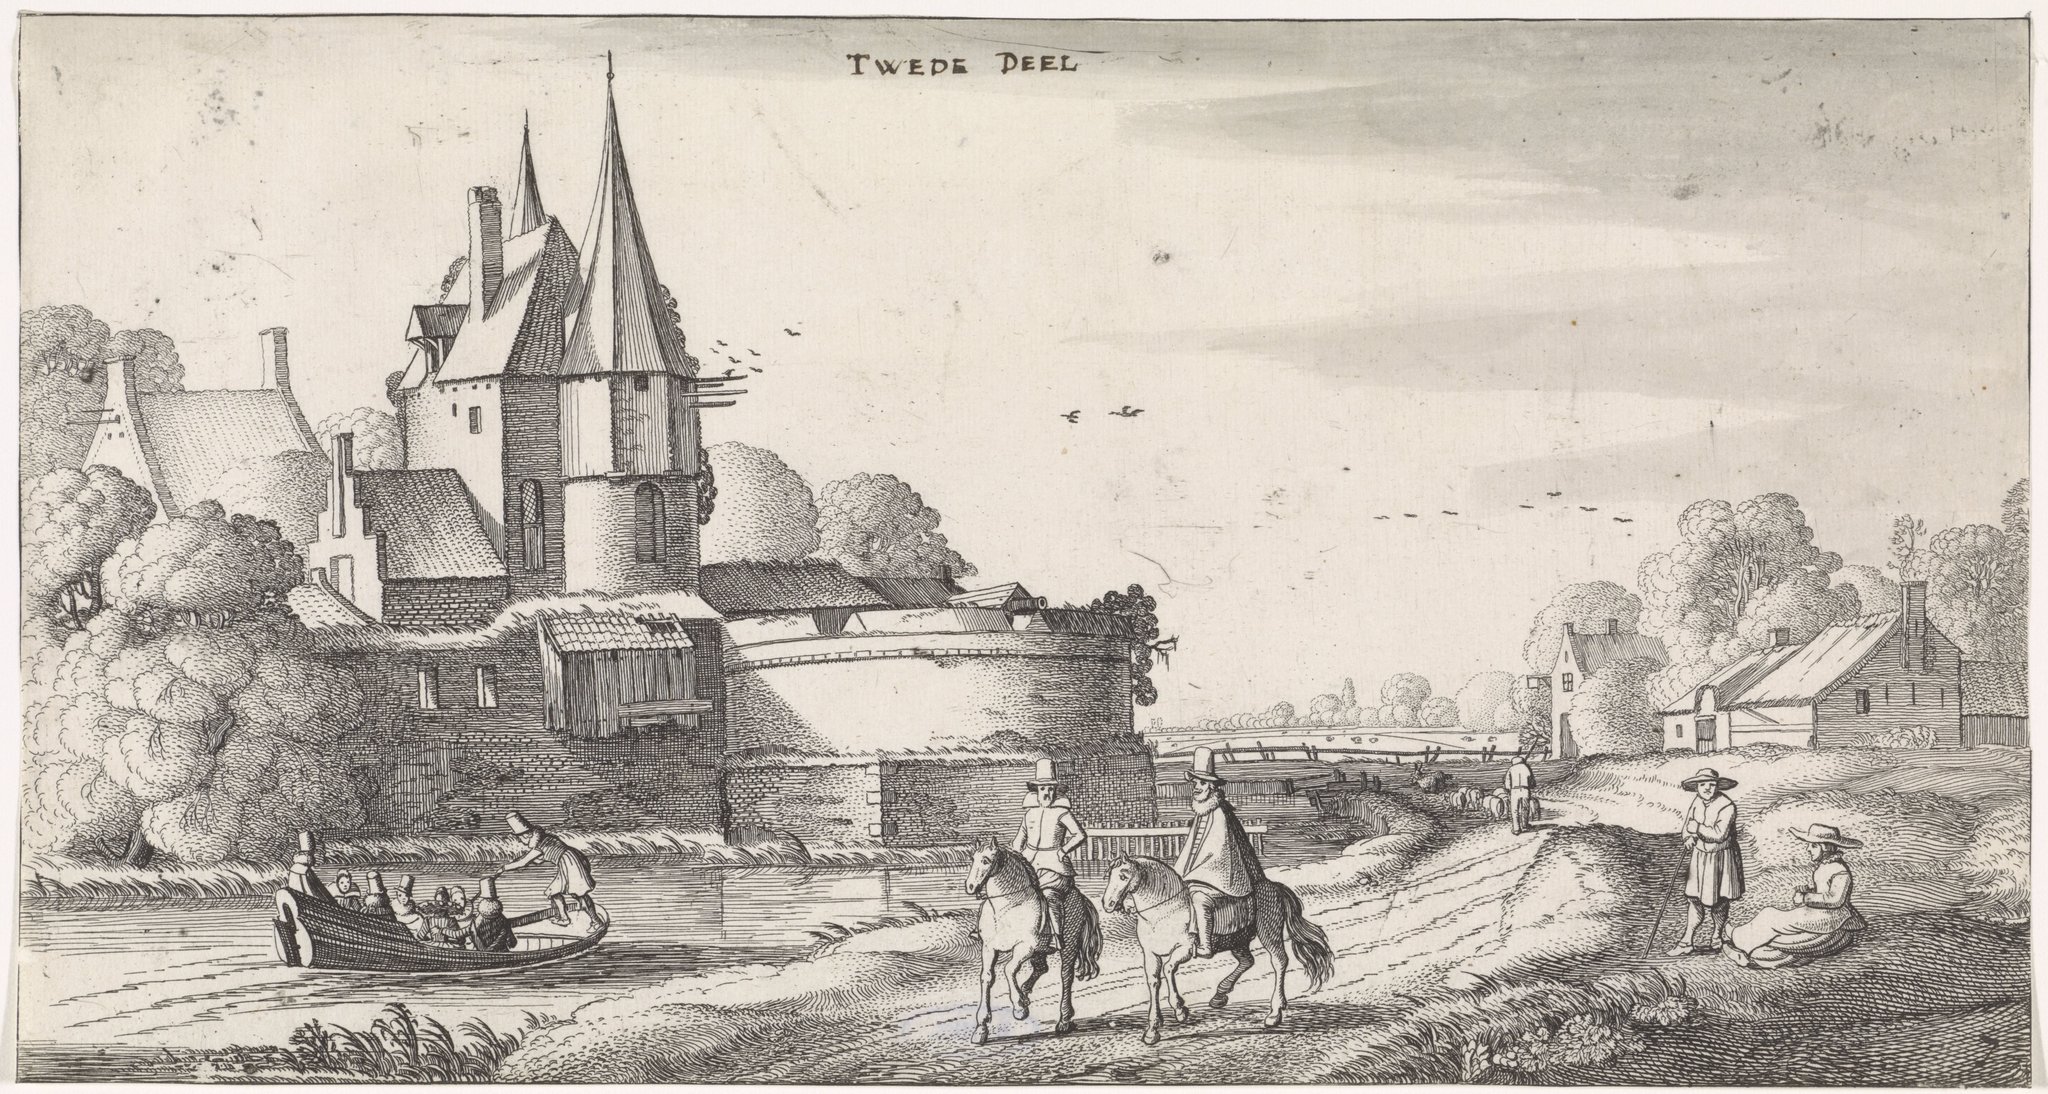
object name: print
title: Playsante lantschappen ende vermakelycke gesichten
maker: jan van de velde (ii)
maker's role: draughtsman, painter, print maker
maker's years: 1593-1641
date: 1639-1641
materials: ink, paper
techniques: brush, etching, pen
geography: northern netherlands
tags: riding a horse, ass, or mule; rider, horseman, river, landscape with tower or castle, bastion, bulwark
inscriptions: number: ‘7’, collector's mark: Lugt 1120, inscription: ‘Twede Deel’, collector's mark: Lugt 2228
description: Twee ruiters op een pad langs een rivier bij een kasteel. Op het water een boot met een elegant gezelschap. Zevende prent van een serie met 36 prenten van landschappen, verdeeld over zes delen.